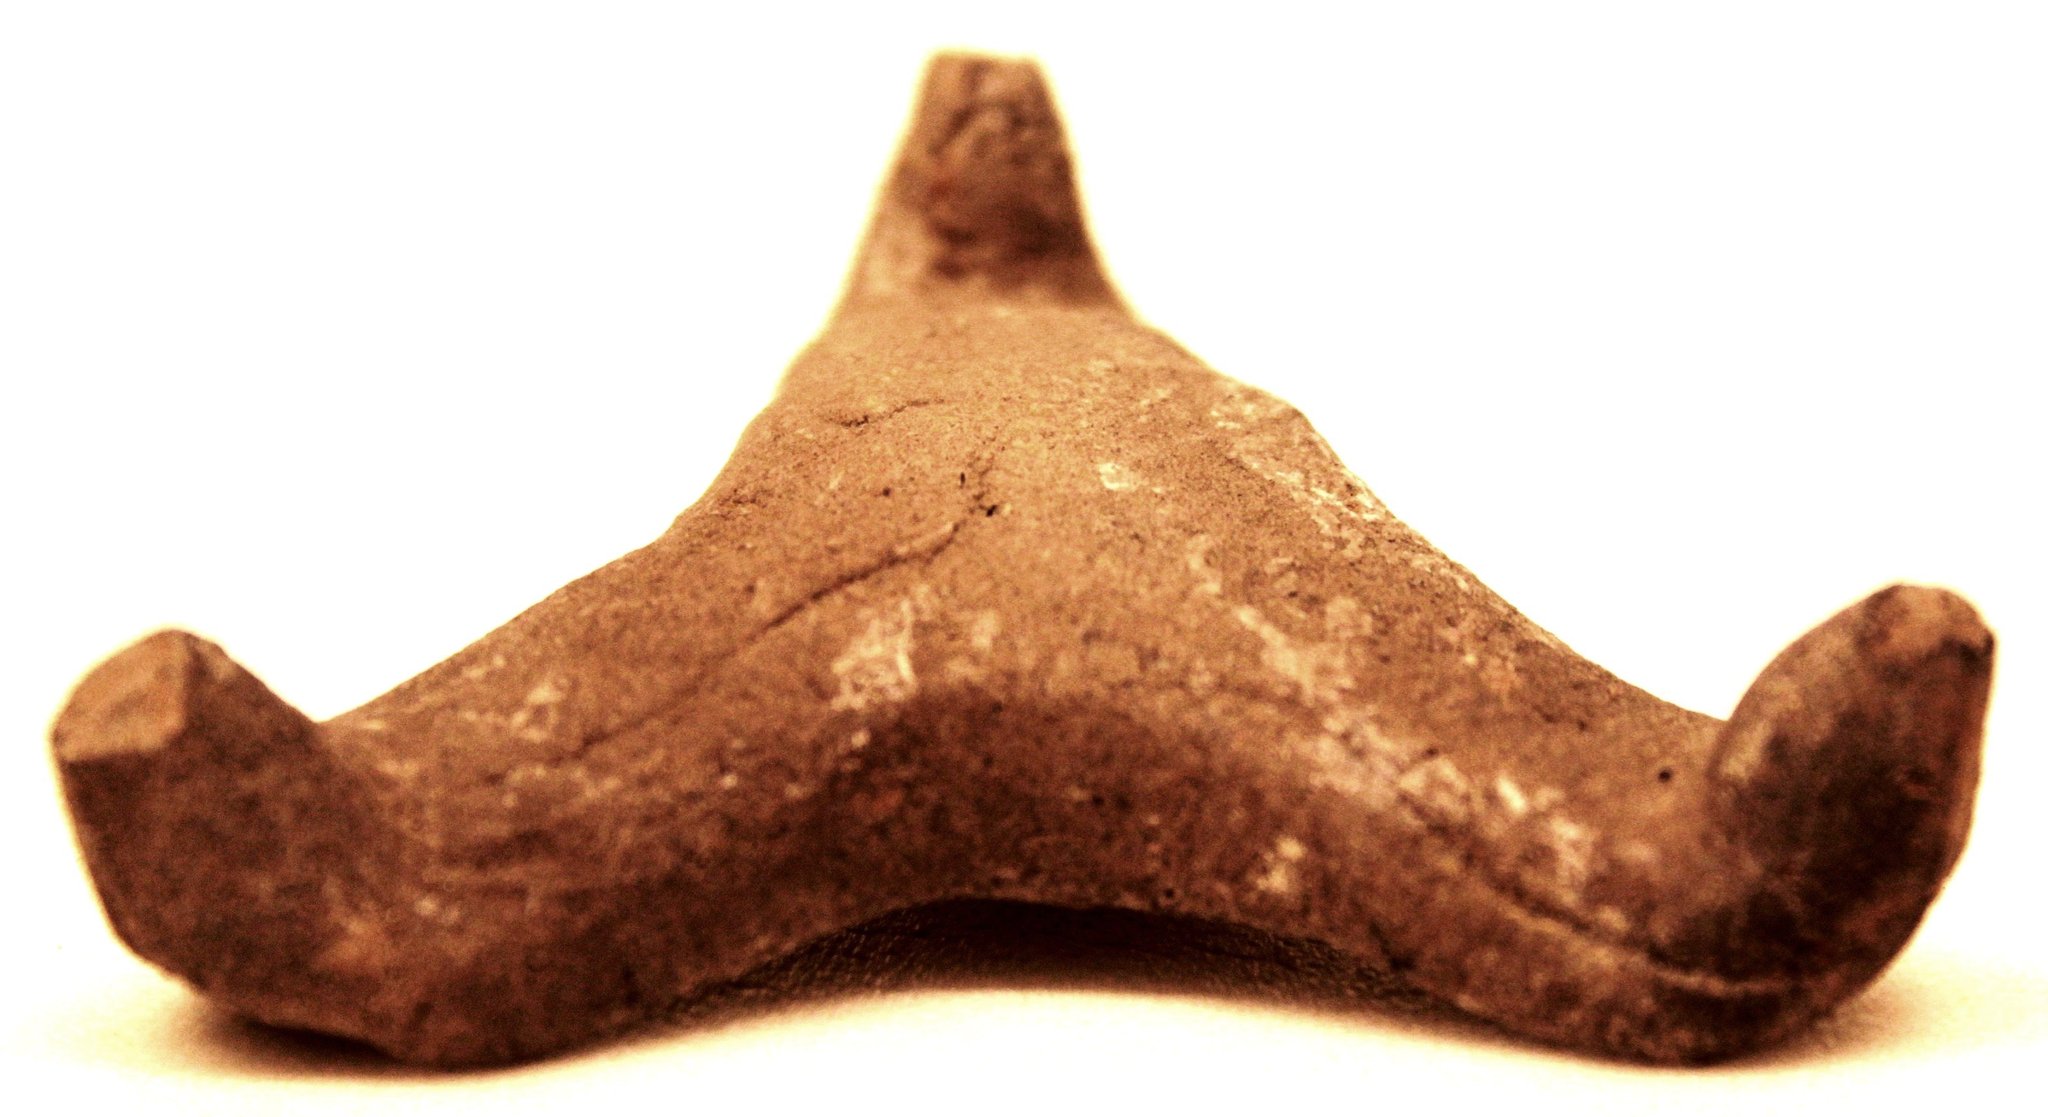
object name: kiln stand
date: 1001-1100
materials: earthenware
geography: iran